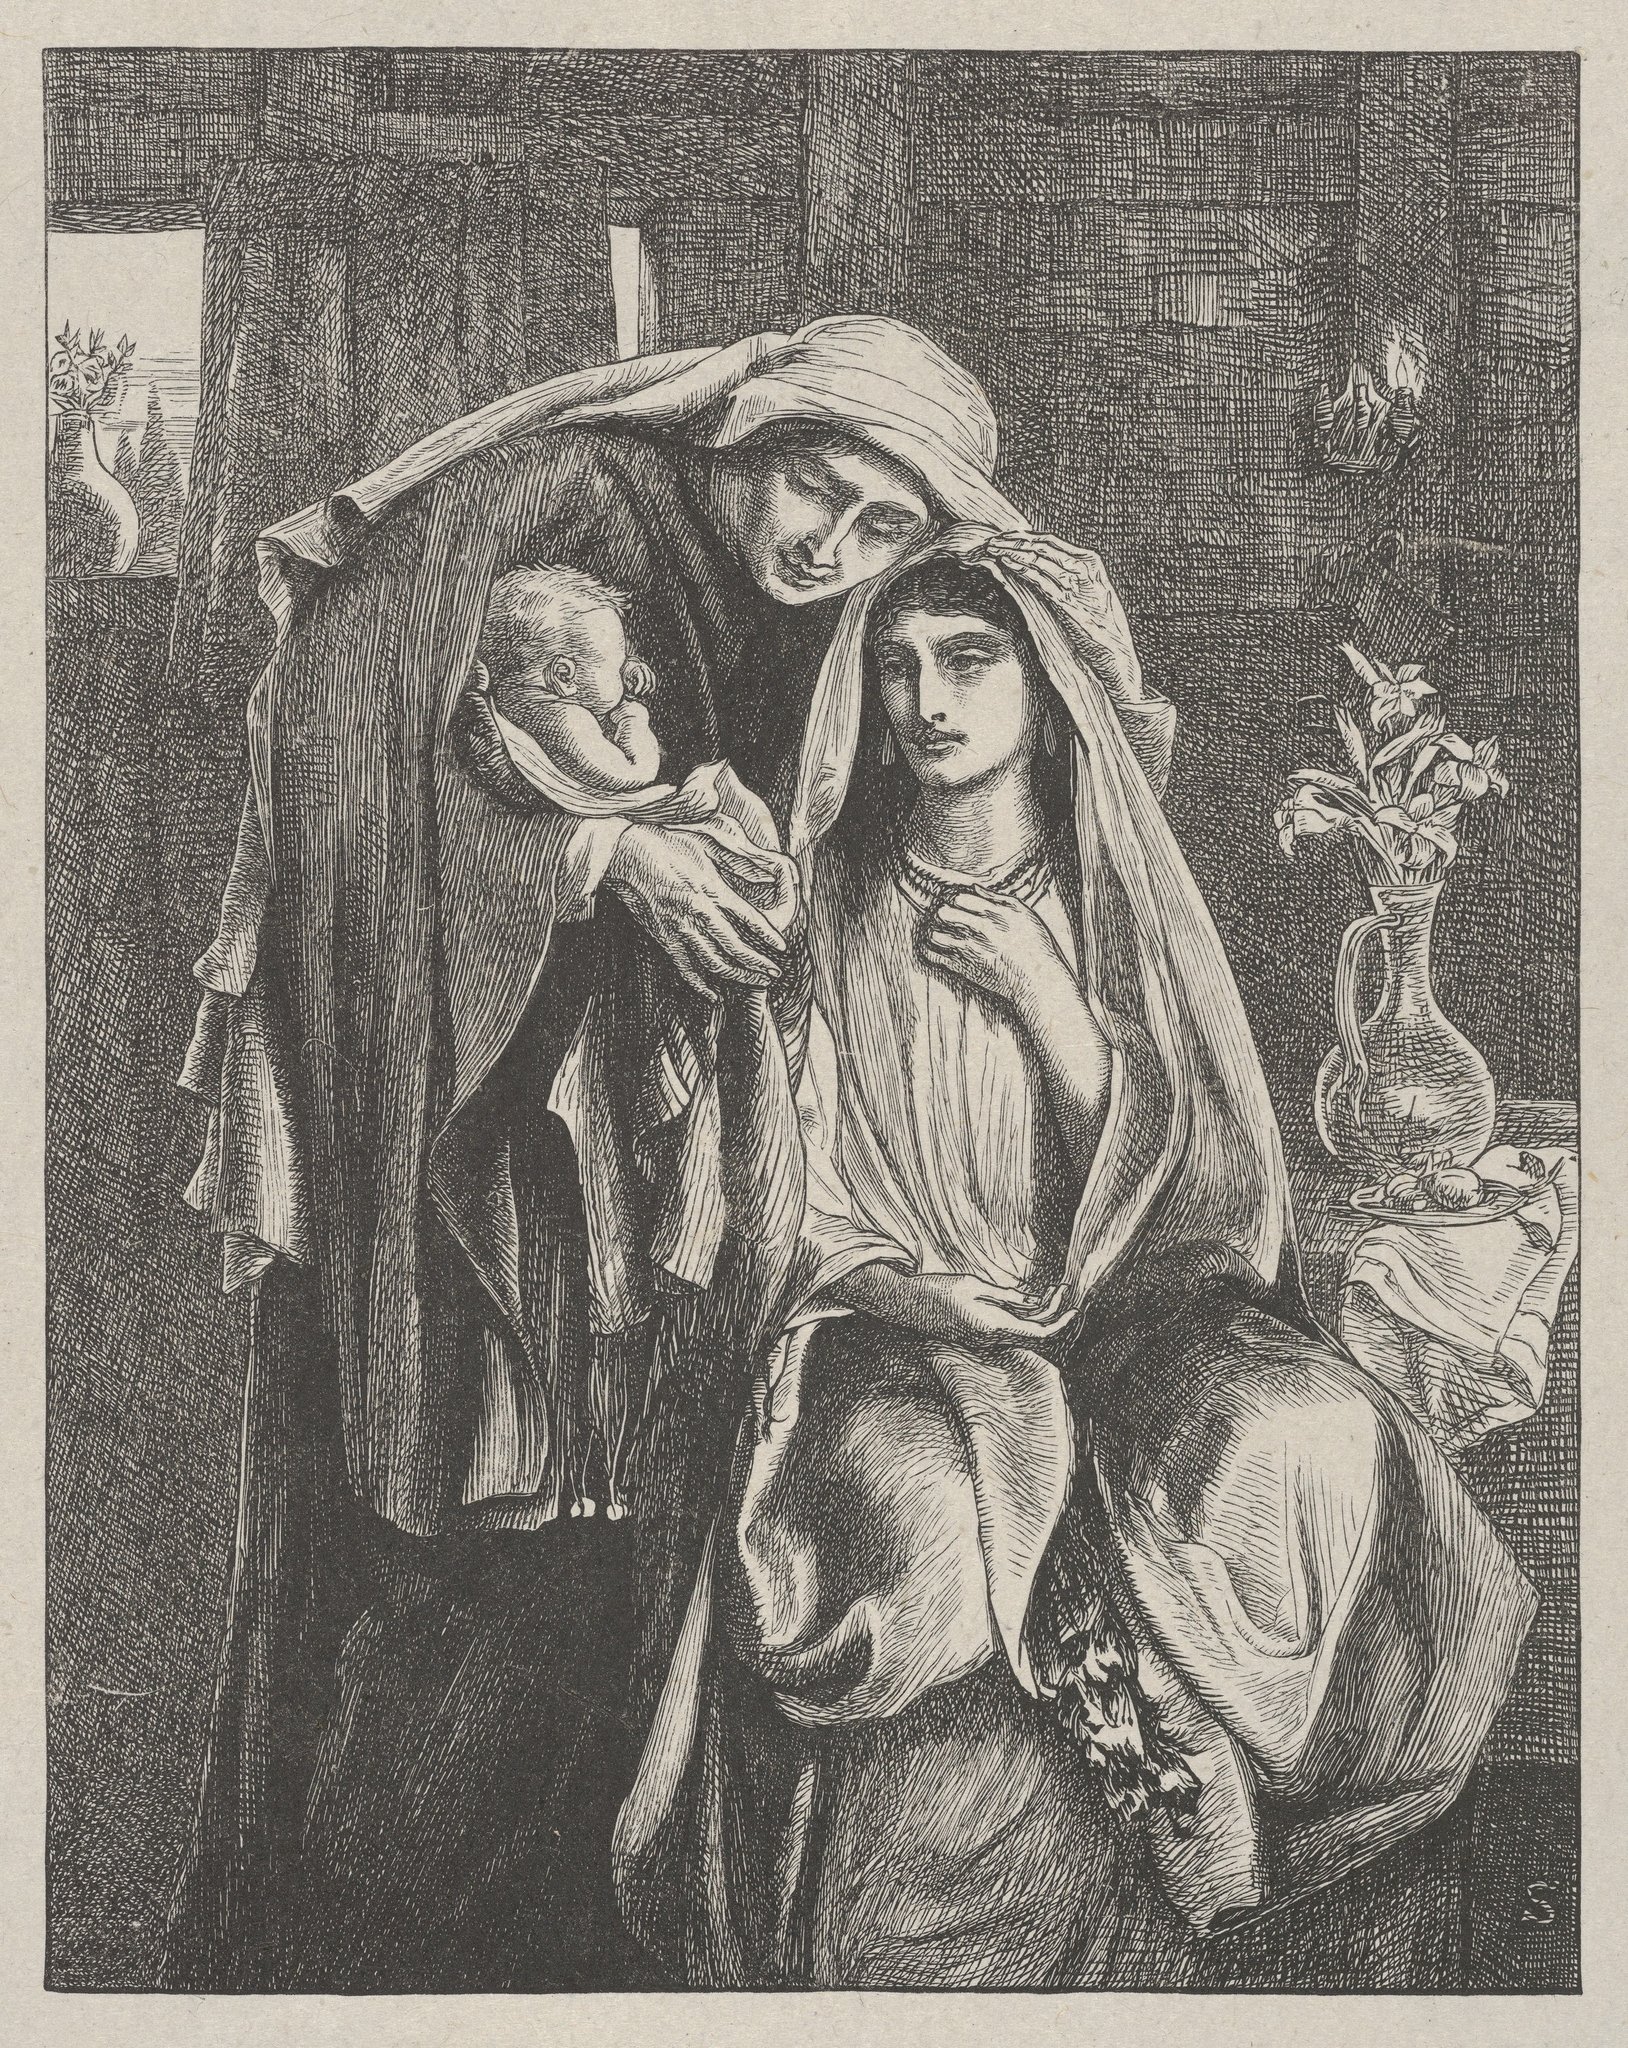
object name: print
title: Naomi and the Child Obed, from "Dalziels' Bible Gallery"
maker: simeon solomon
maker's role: artist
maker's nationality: british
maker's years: 1840-1905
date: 1863-1881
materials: paper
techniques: engraving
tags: infants,women